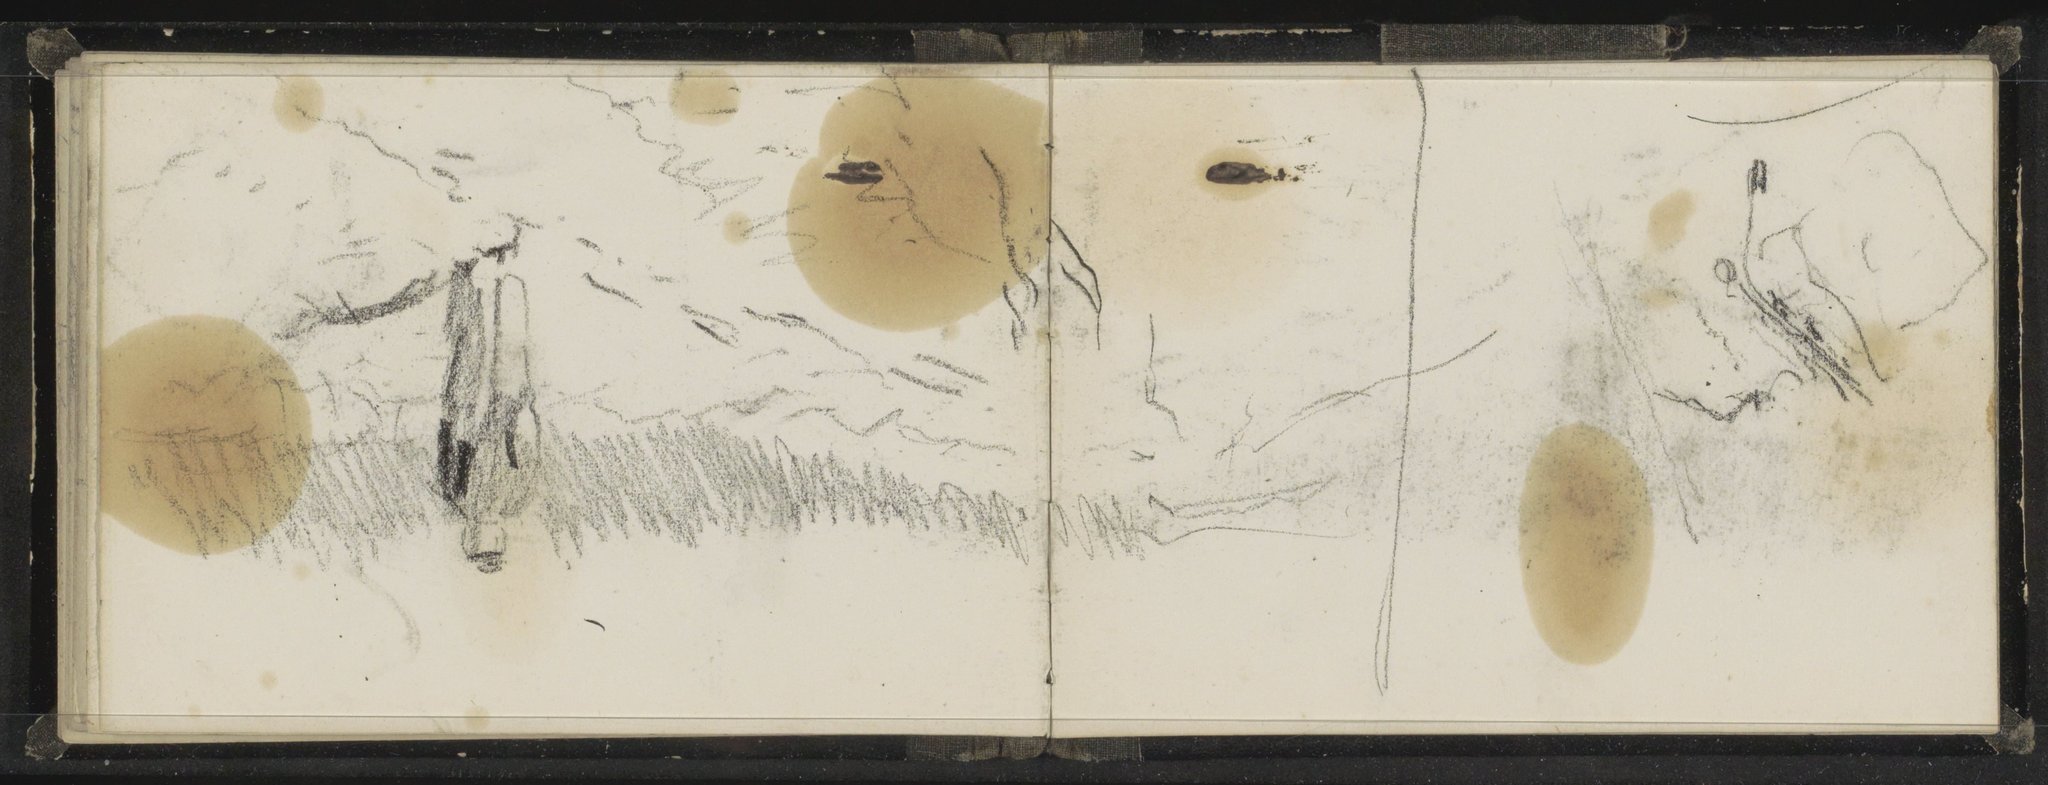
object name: sketchbook leaf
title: Landschap met een staande figuur bij een heg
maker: anton mauve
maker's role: draughtsman, painter, print maker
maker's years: 1838-1888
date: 1848-1888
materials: chalk, paper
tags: landscapes (+ landscape with figures, staffage)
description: Blad 29 verso en 30 recto uit een schetsboek met 33 bladen.